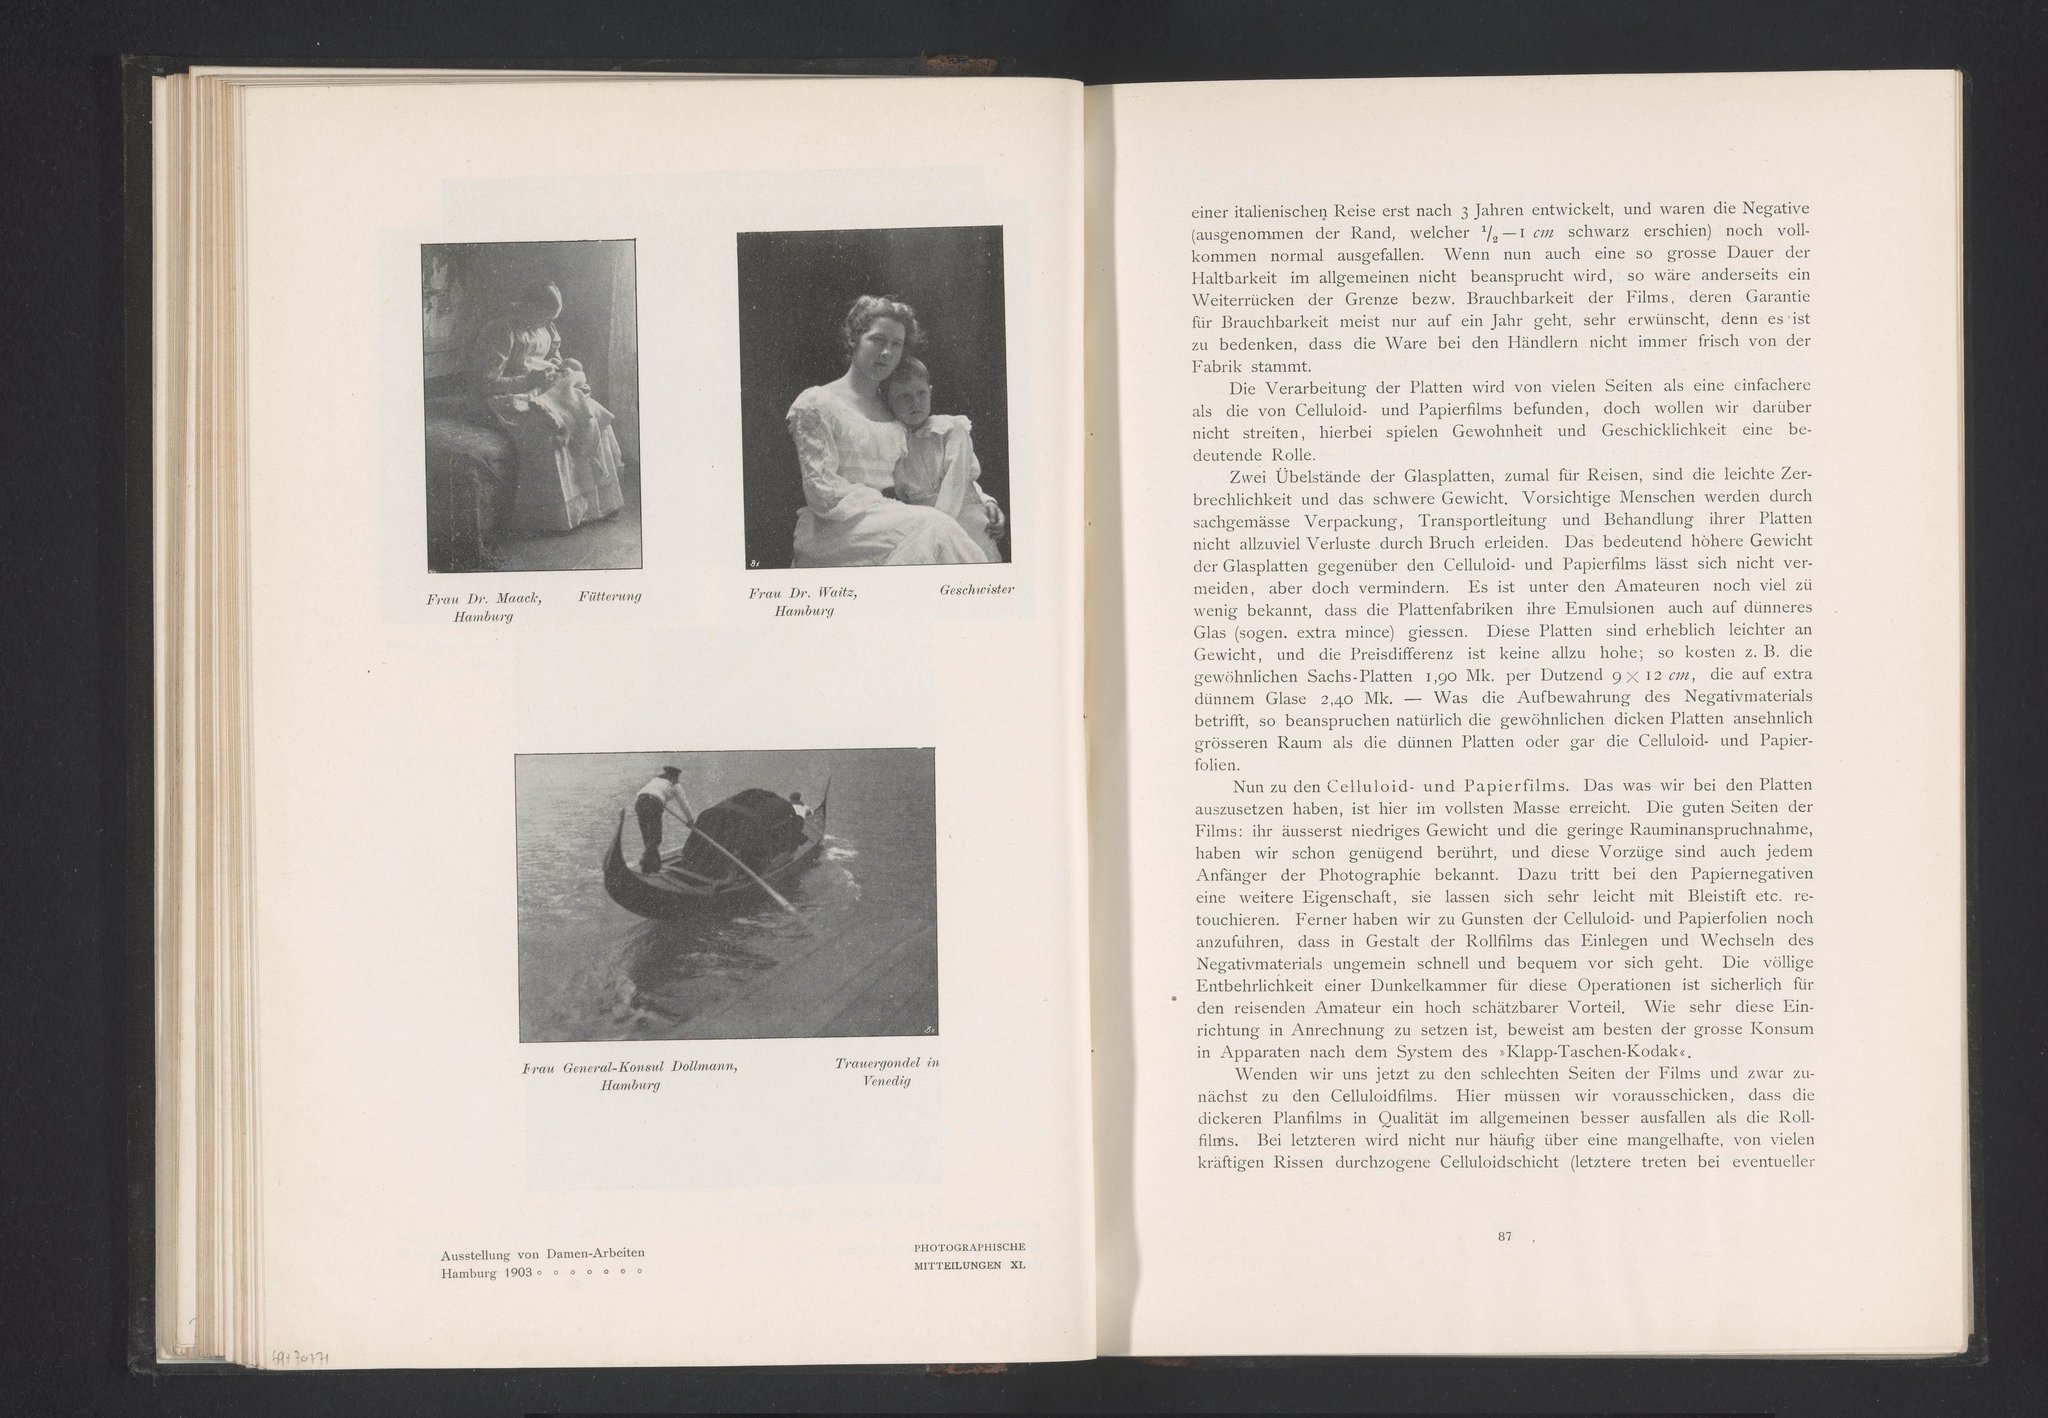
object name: photomechanical print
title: Fütterung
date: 1898-1903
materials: paper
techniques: autotype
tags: feeding a baby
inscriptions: monogram: ‘BX’, inscription: ‘Frau Dr. Maack, Hamburg’